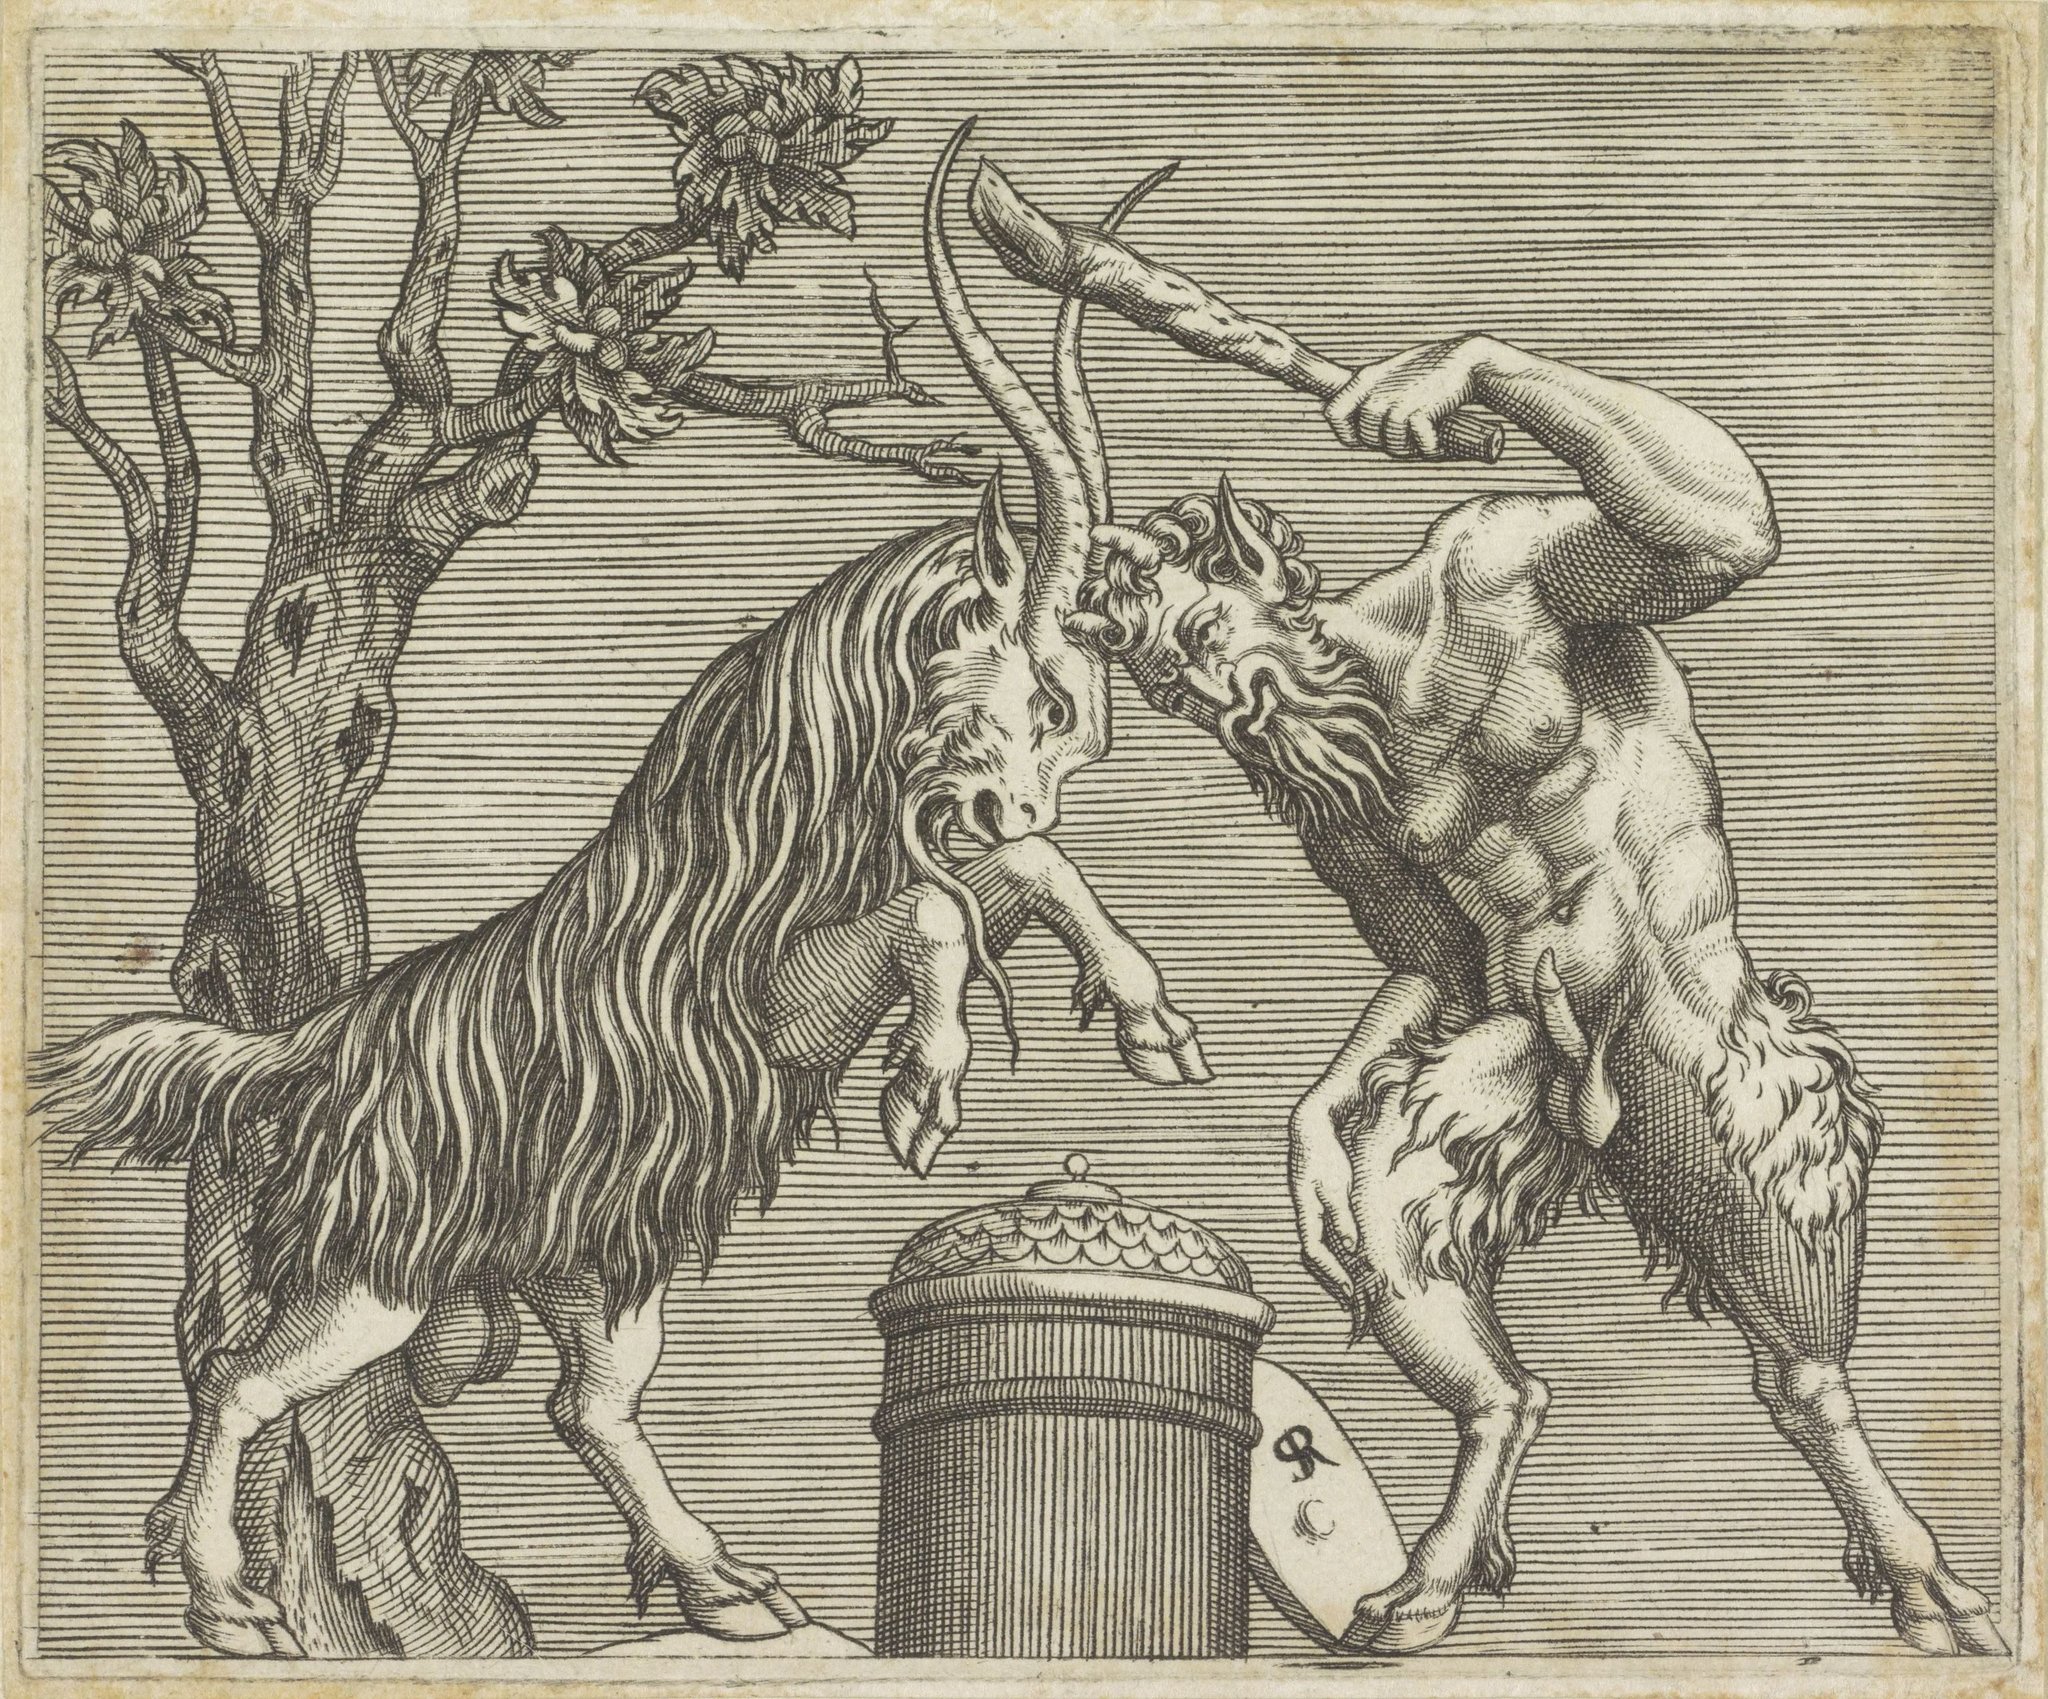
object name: print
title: Antieke reliëfs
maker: marco dente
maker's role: print maker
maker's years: 1486-1527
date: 1498-1532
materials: paper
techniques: engraving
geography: italy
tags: ram, satyr(s) (in general), fighting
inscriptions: collector's mark: Lugt 12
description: Een sater en een ram in gevecht. Op de achtergrond links een boom.